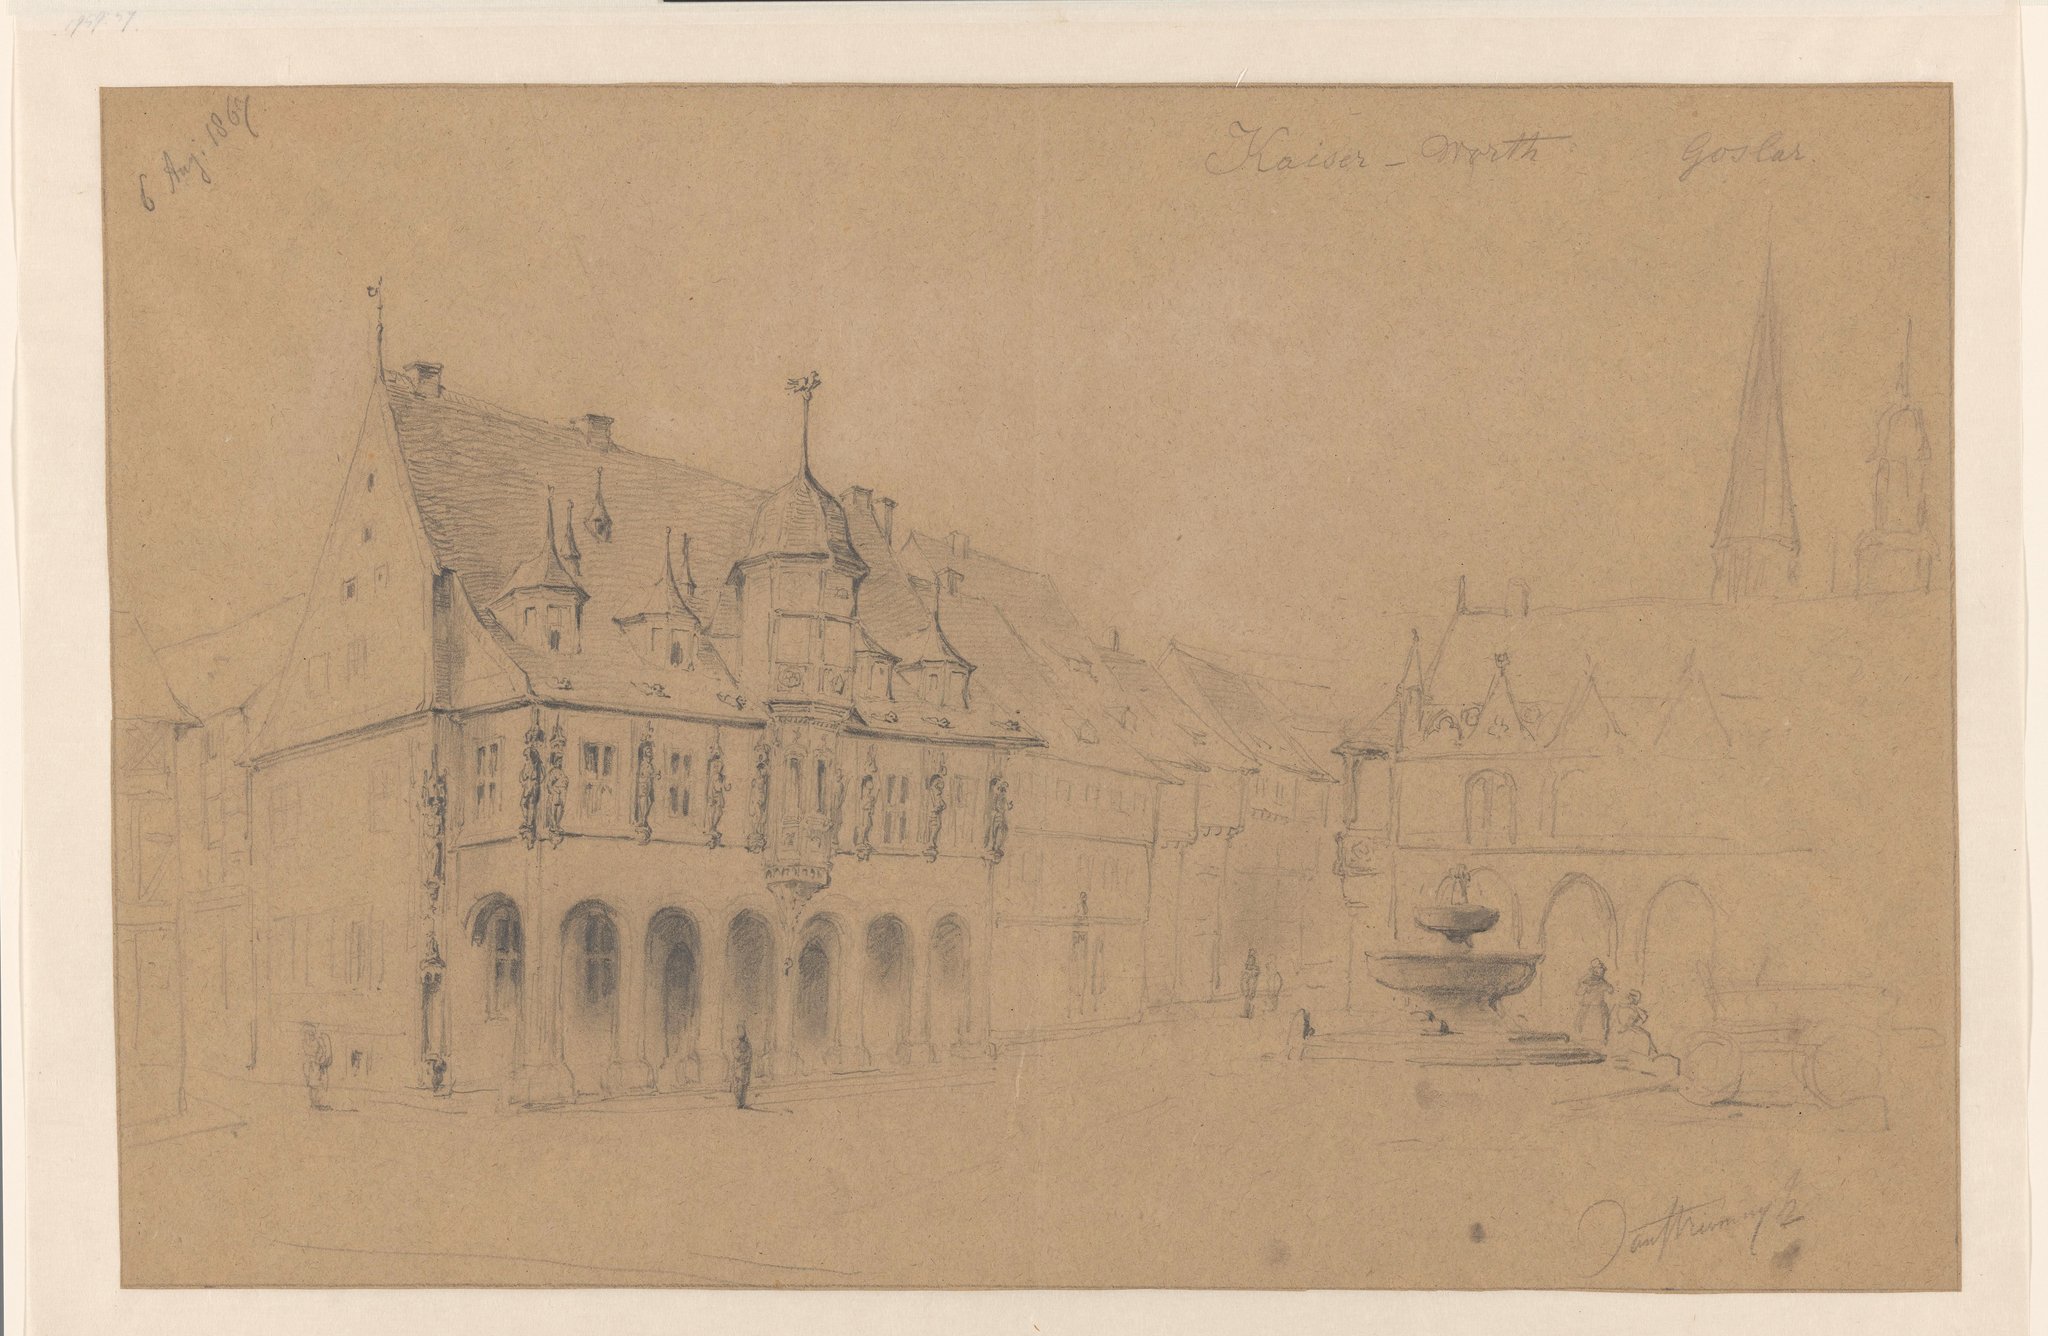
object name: drawing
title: Stadsplein met de Kaiser Warth te Goslar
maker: jan striening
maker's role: draughtsman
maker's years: 1827-1903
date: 1867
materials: paper, pencil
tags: square, place, circus, etc., germany